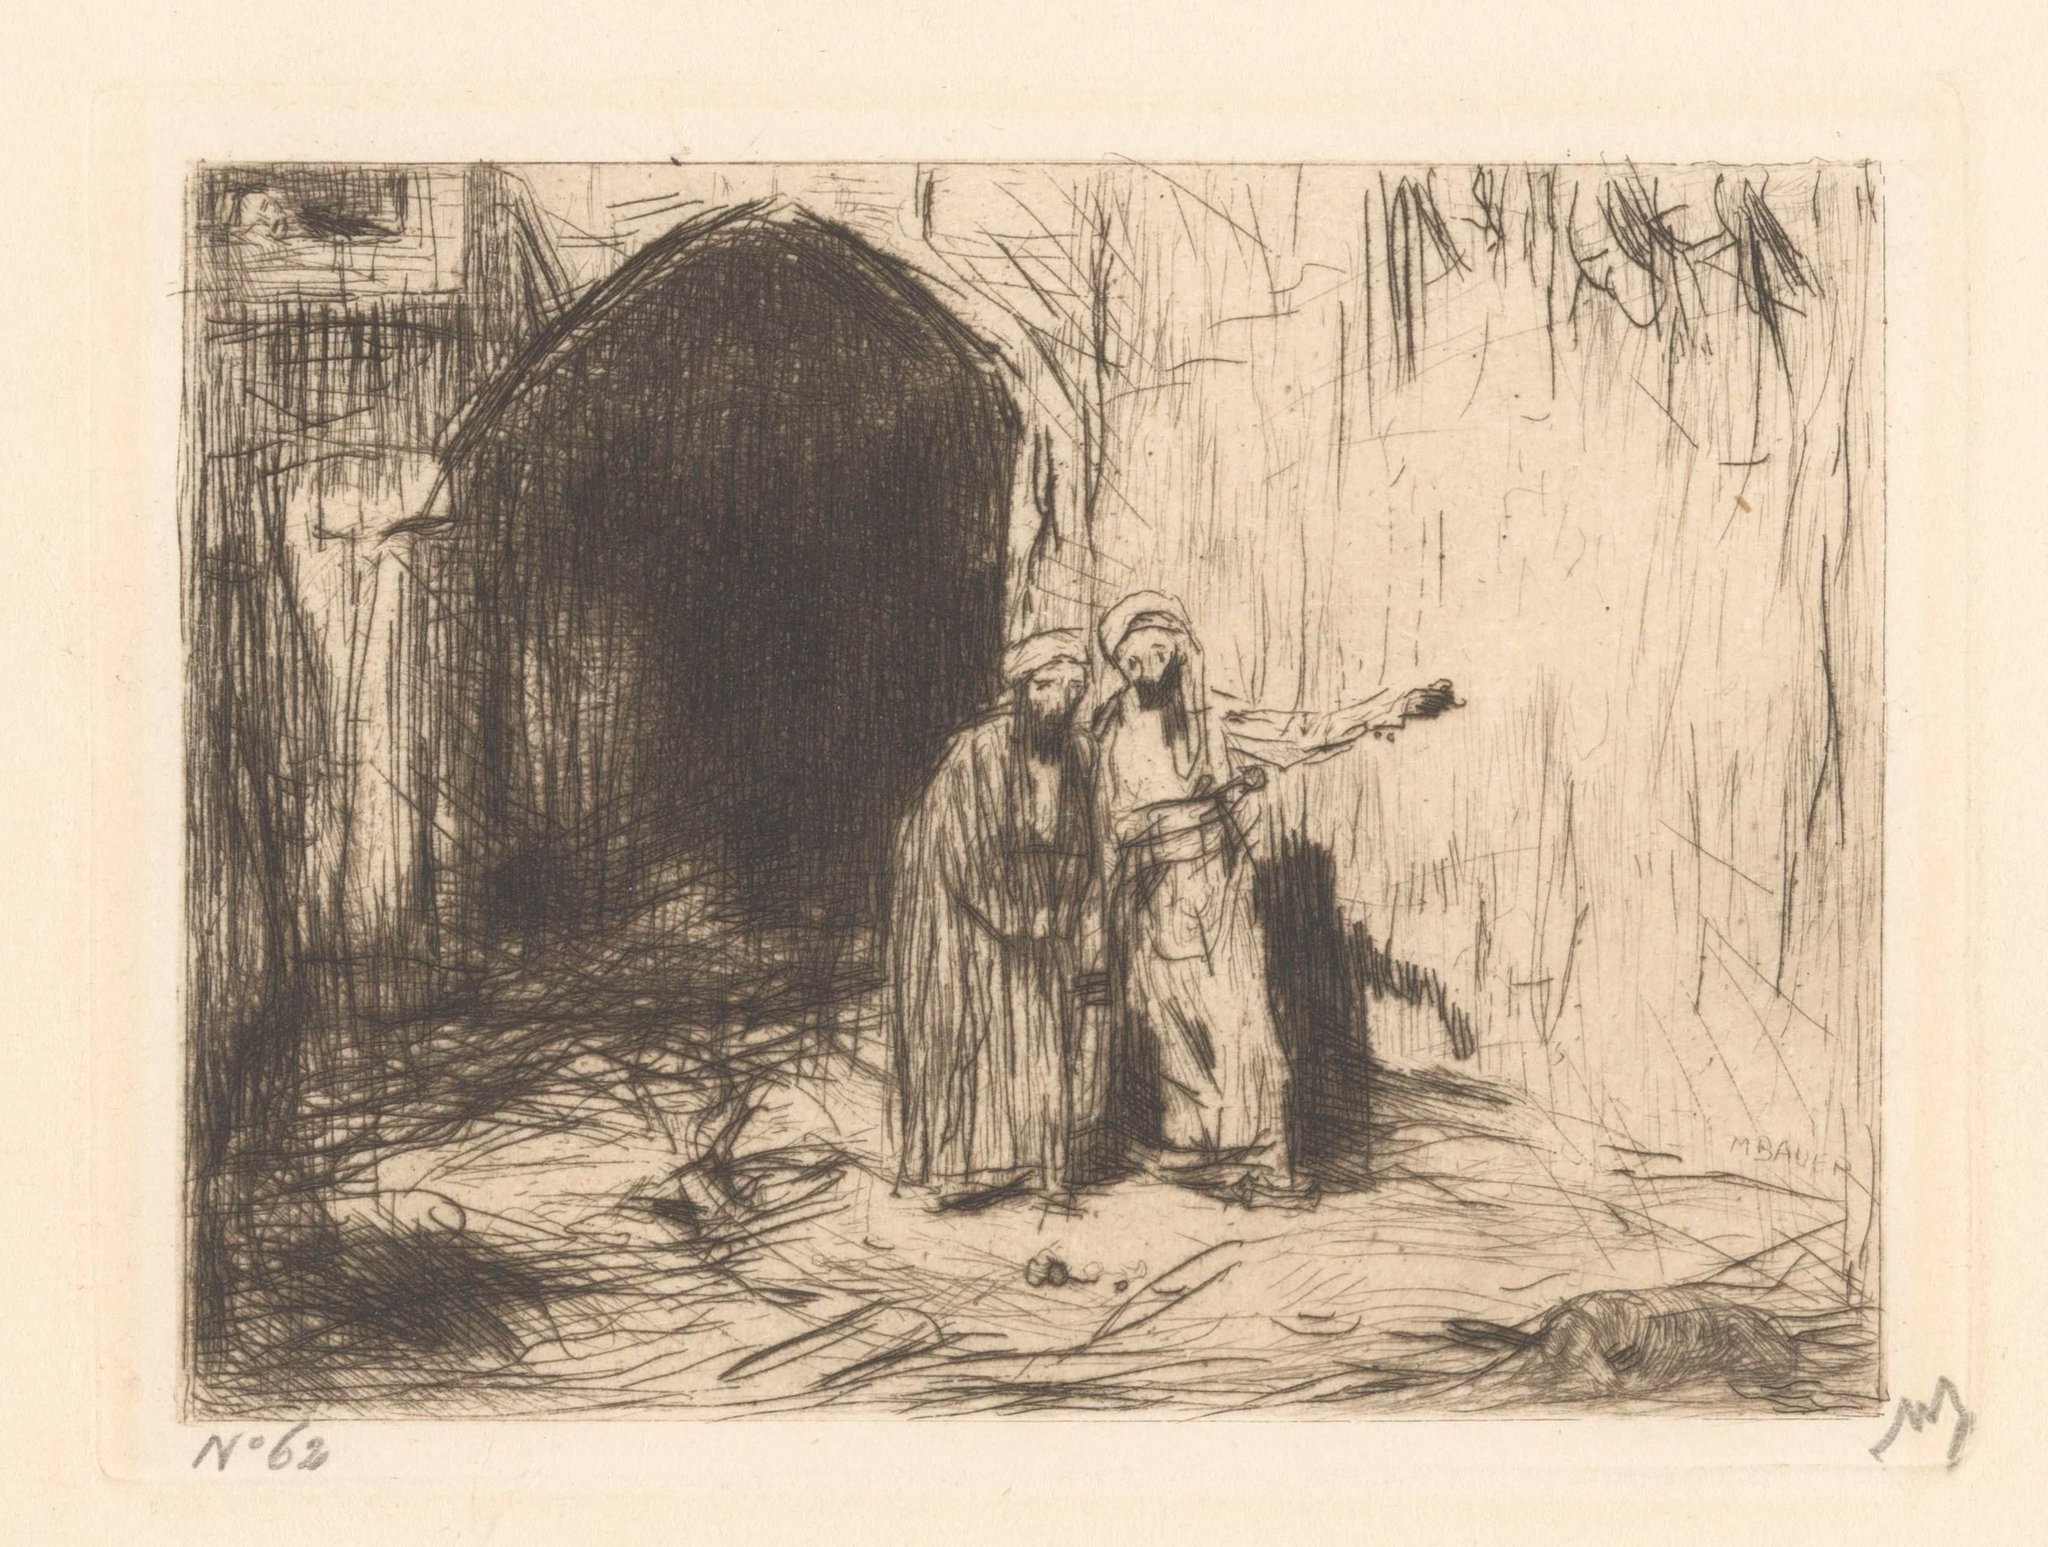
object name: print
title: Poort in een Ottomaanse stad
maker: marius bauer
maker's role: draughtsman, print maker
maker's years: 1867-1932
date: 1889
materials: paper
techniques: etching, intaglio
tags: gate, entrance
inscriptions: collector's mark: Lugt 2228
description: Twee mannen in oosterse kleding lopend voor een poort.